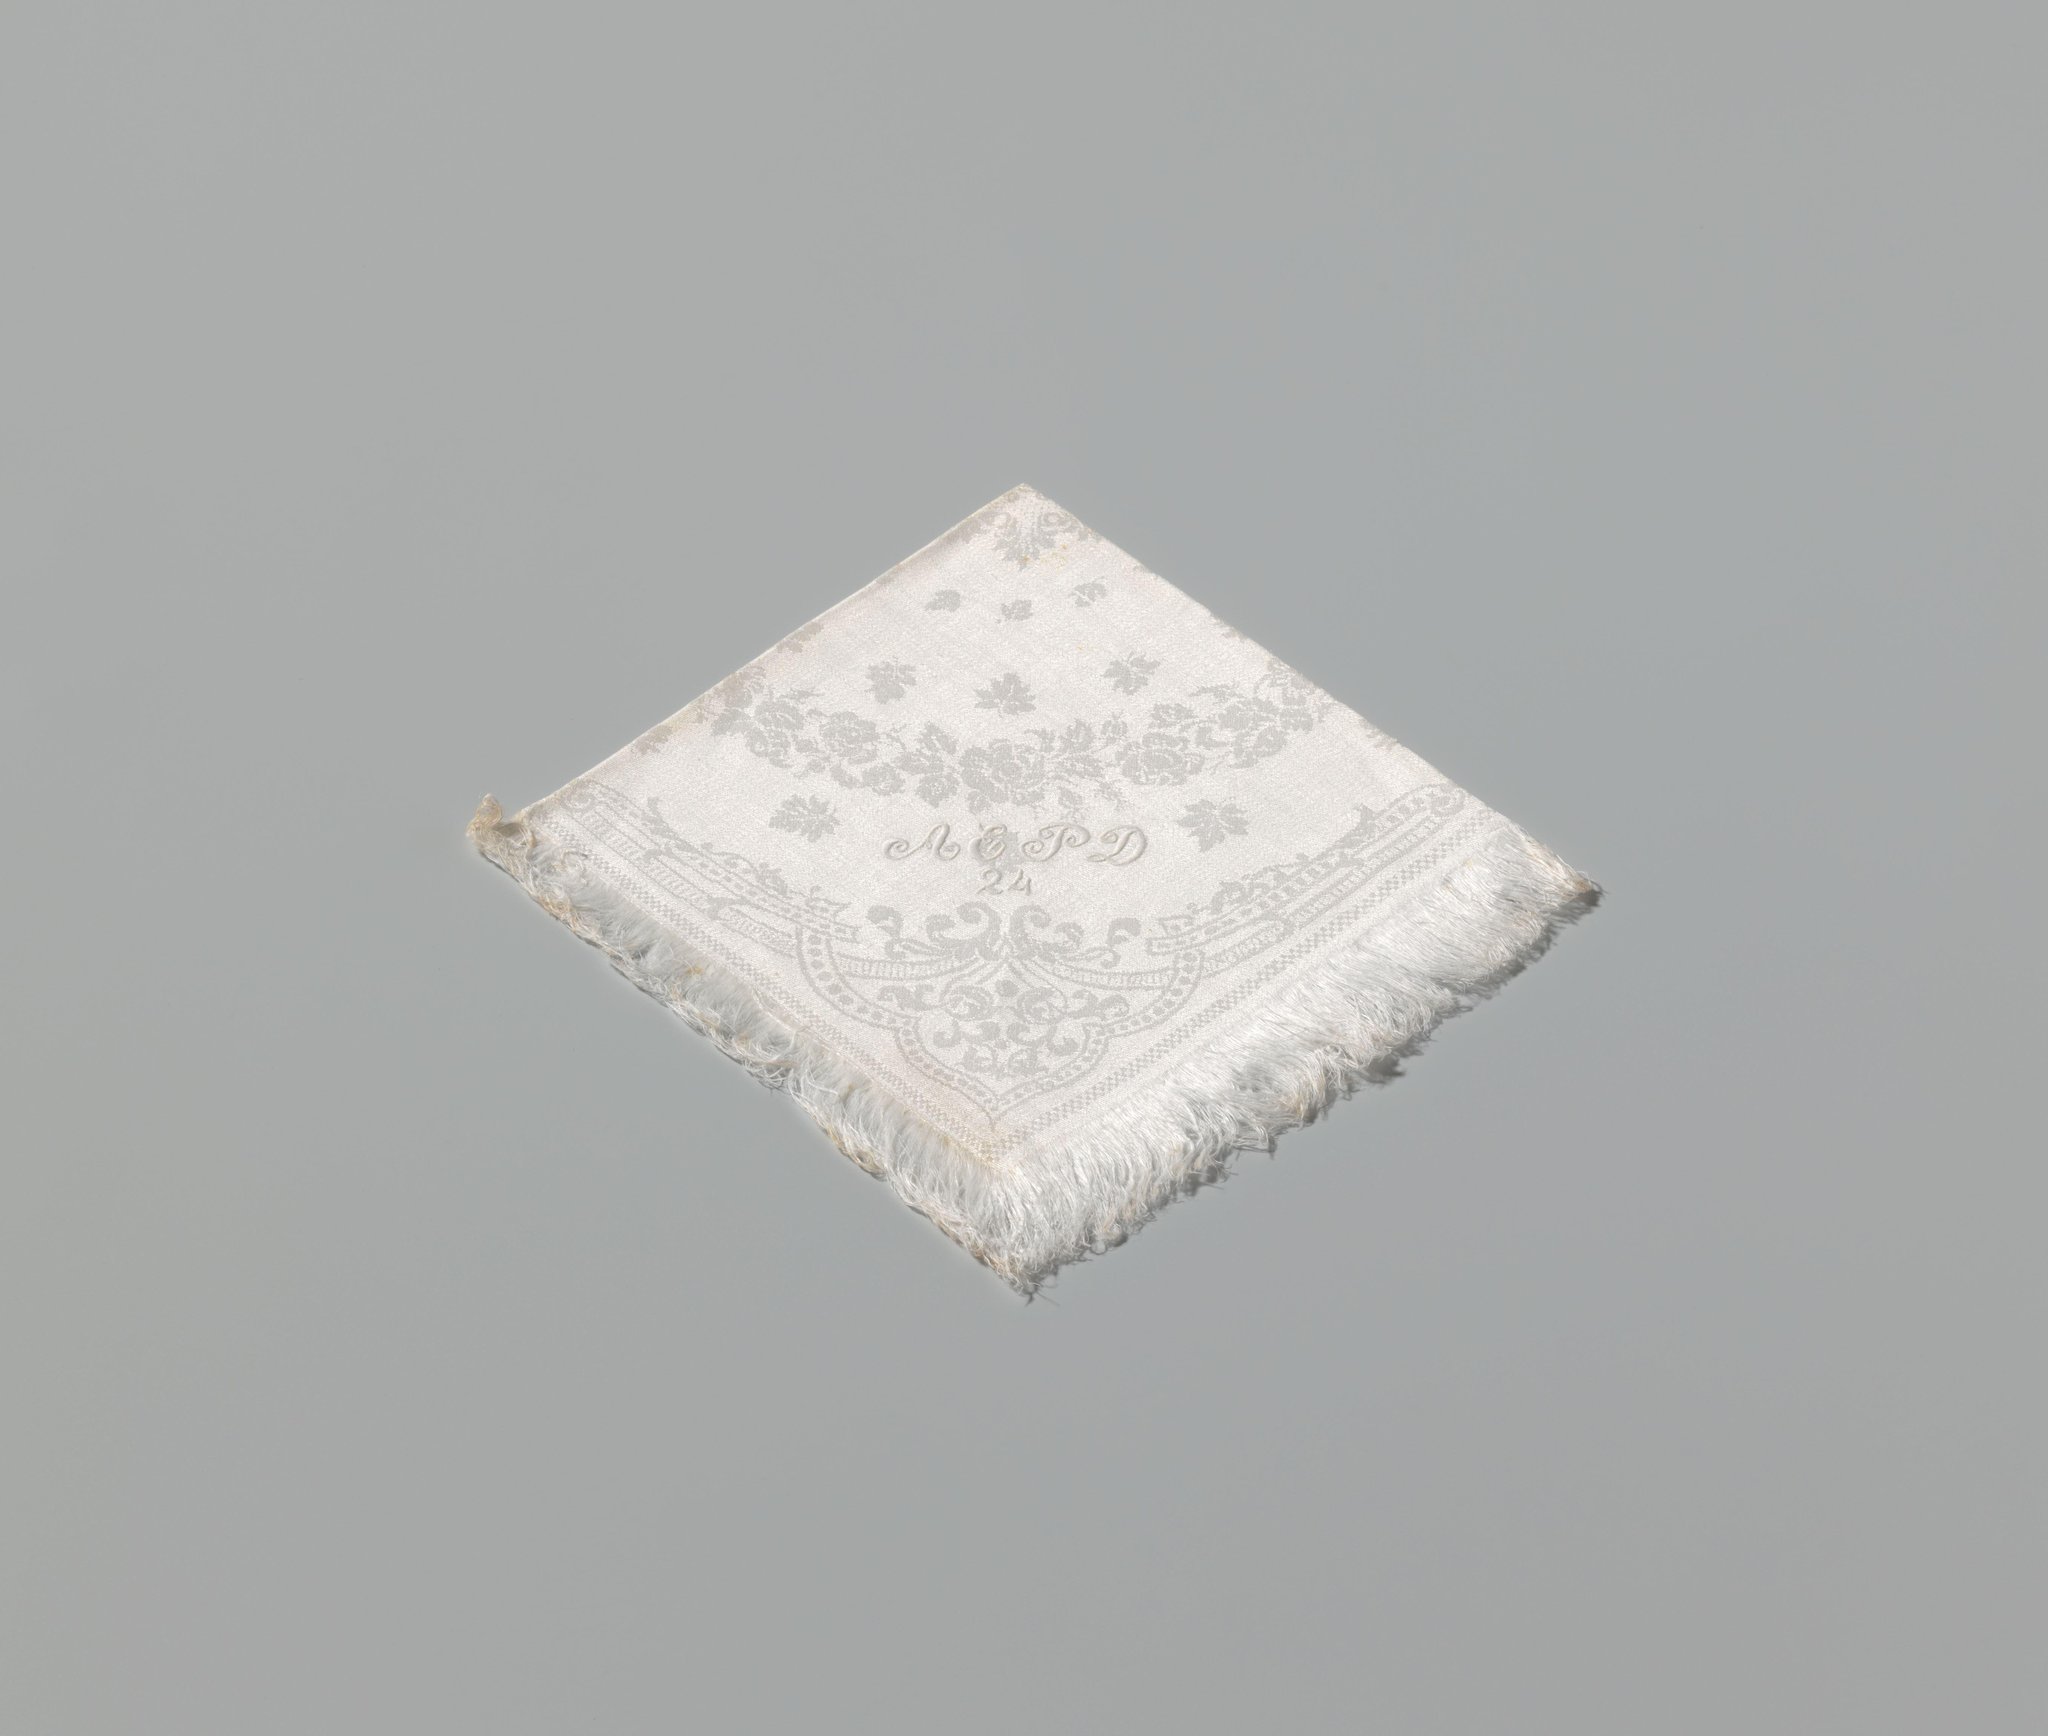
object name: vingerdoek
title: Vingerdoek van linnendamast met een bloempatroon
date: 1875-1900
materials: linen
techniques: damask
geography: netherlands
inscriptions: monogram: ‘AEDP 24’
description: Vingerdoek van linnendamast met op het veld een bloemenkrans waarbinnen een rozet van bladeren en waaromheen gestrooide bladeren. Langs de rand een bloempatroon. De vingerdoek heeft franje langs de rand en in wit geborduurde letters AEPD24. De vingerdoek hoort bij negen vingerdoeken (BK-1979-269-A t/m BK-1979-269-J).